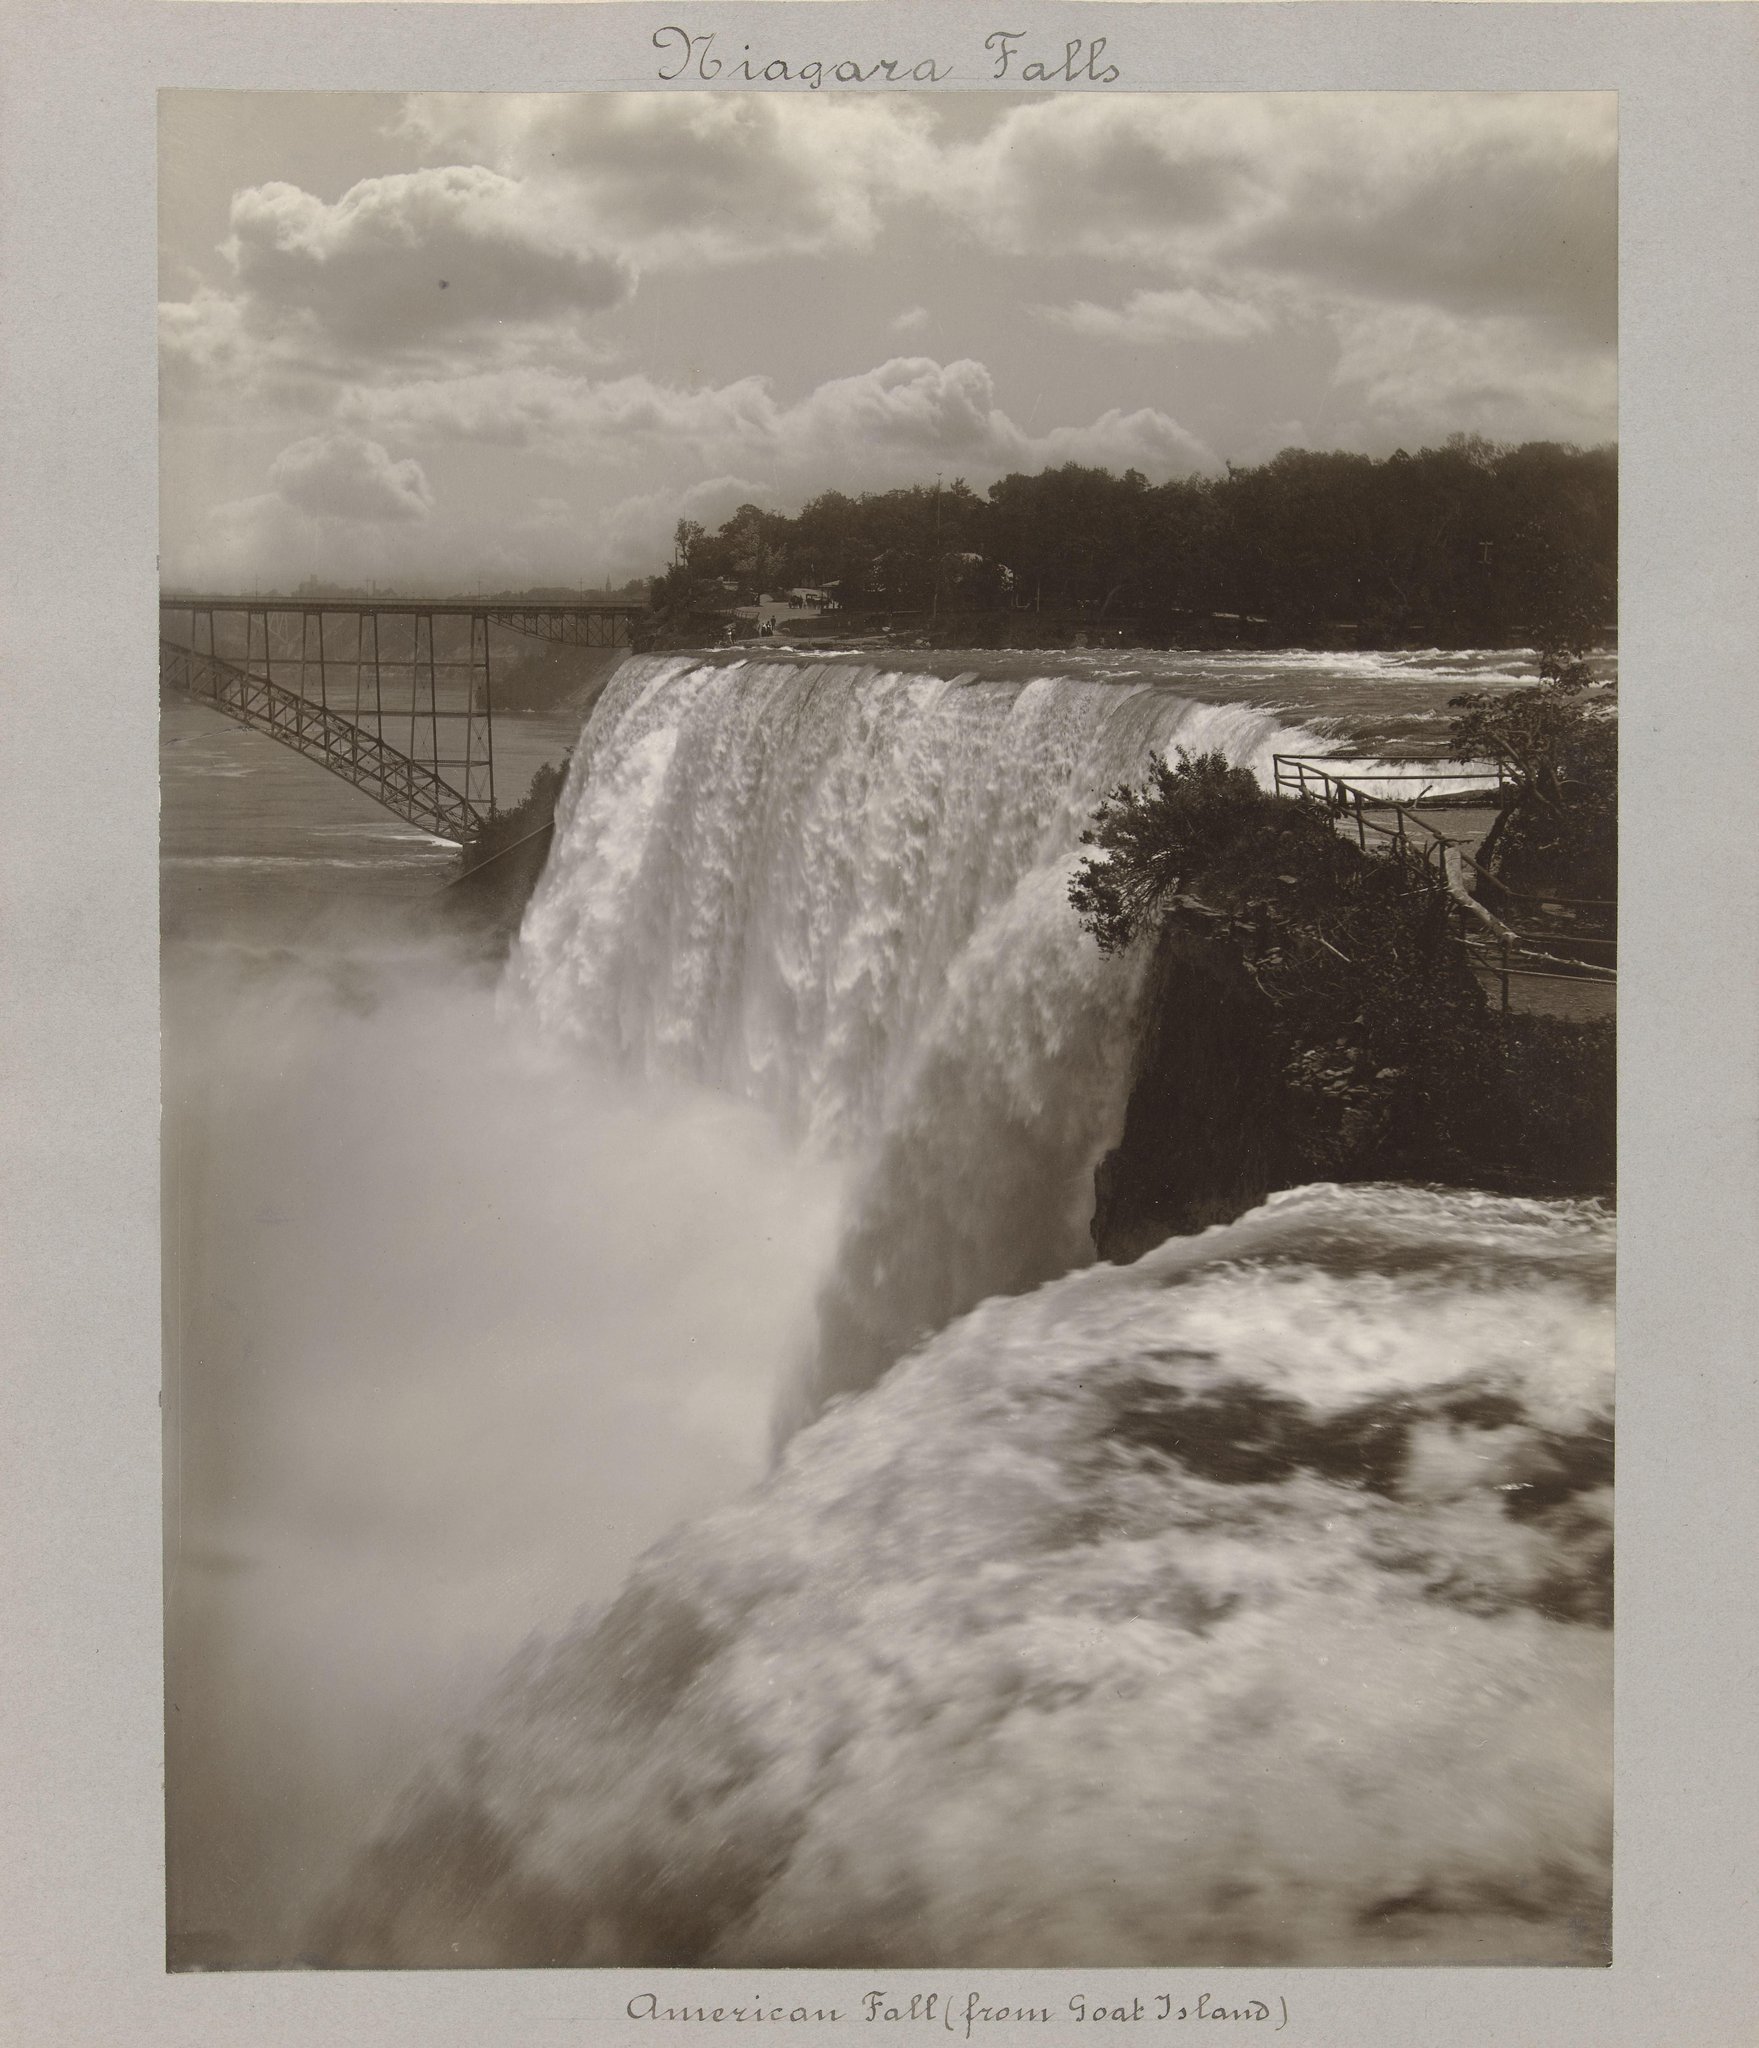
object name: photograph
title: Gezicht op de American Falls bij de Niagarawatervallen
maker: h.f. nielson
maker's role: fotograaf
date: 1898-1925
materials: cardboard, paper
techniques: albumen print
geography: niagara falls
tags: waterfall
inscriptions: inscription: ‘Niagara Falls/ American Fall (from Goat Island)’